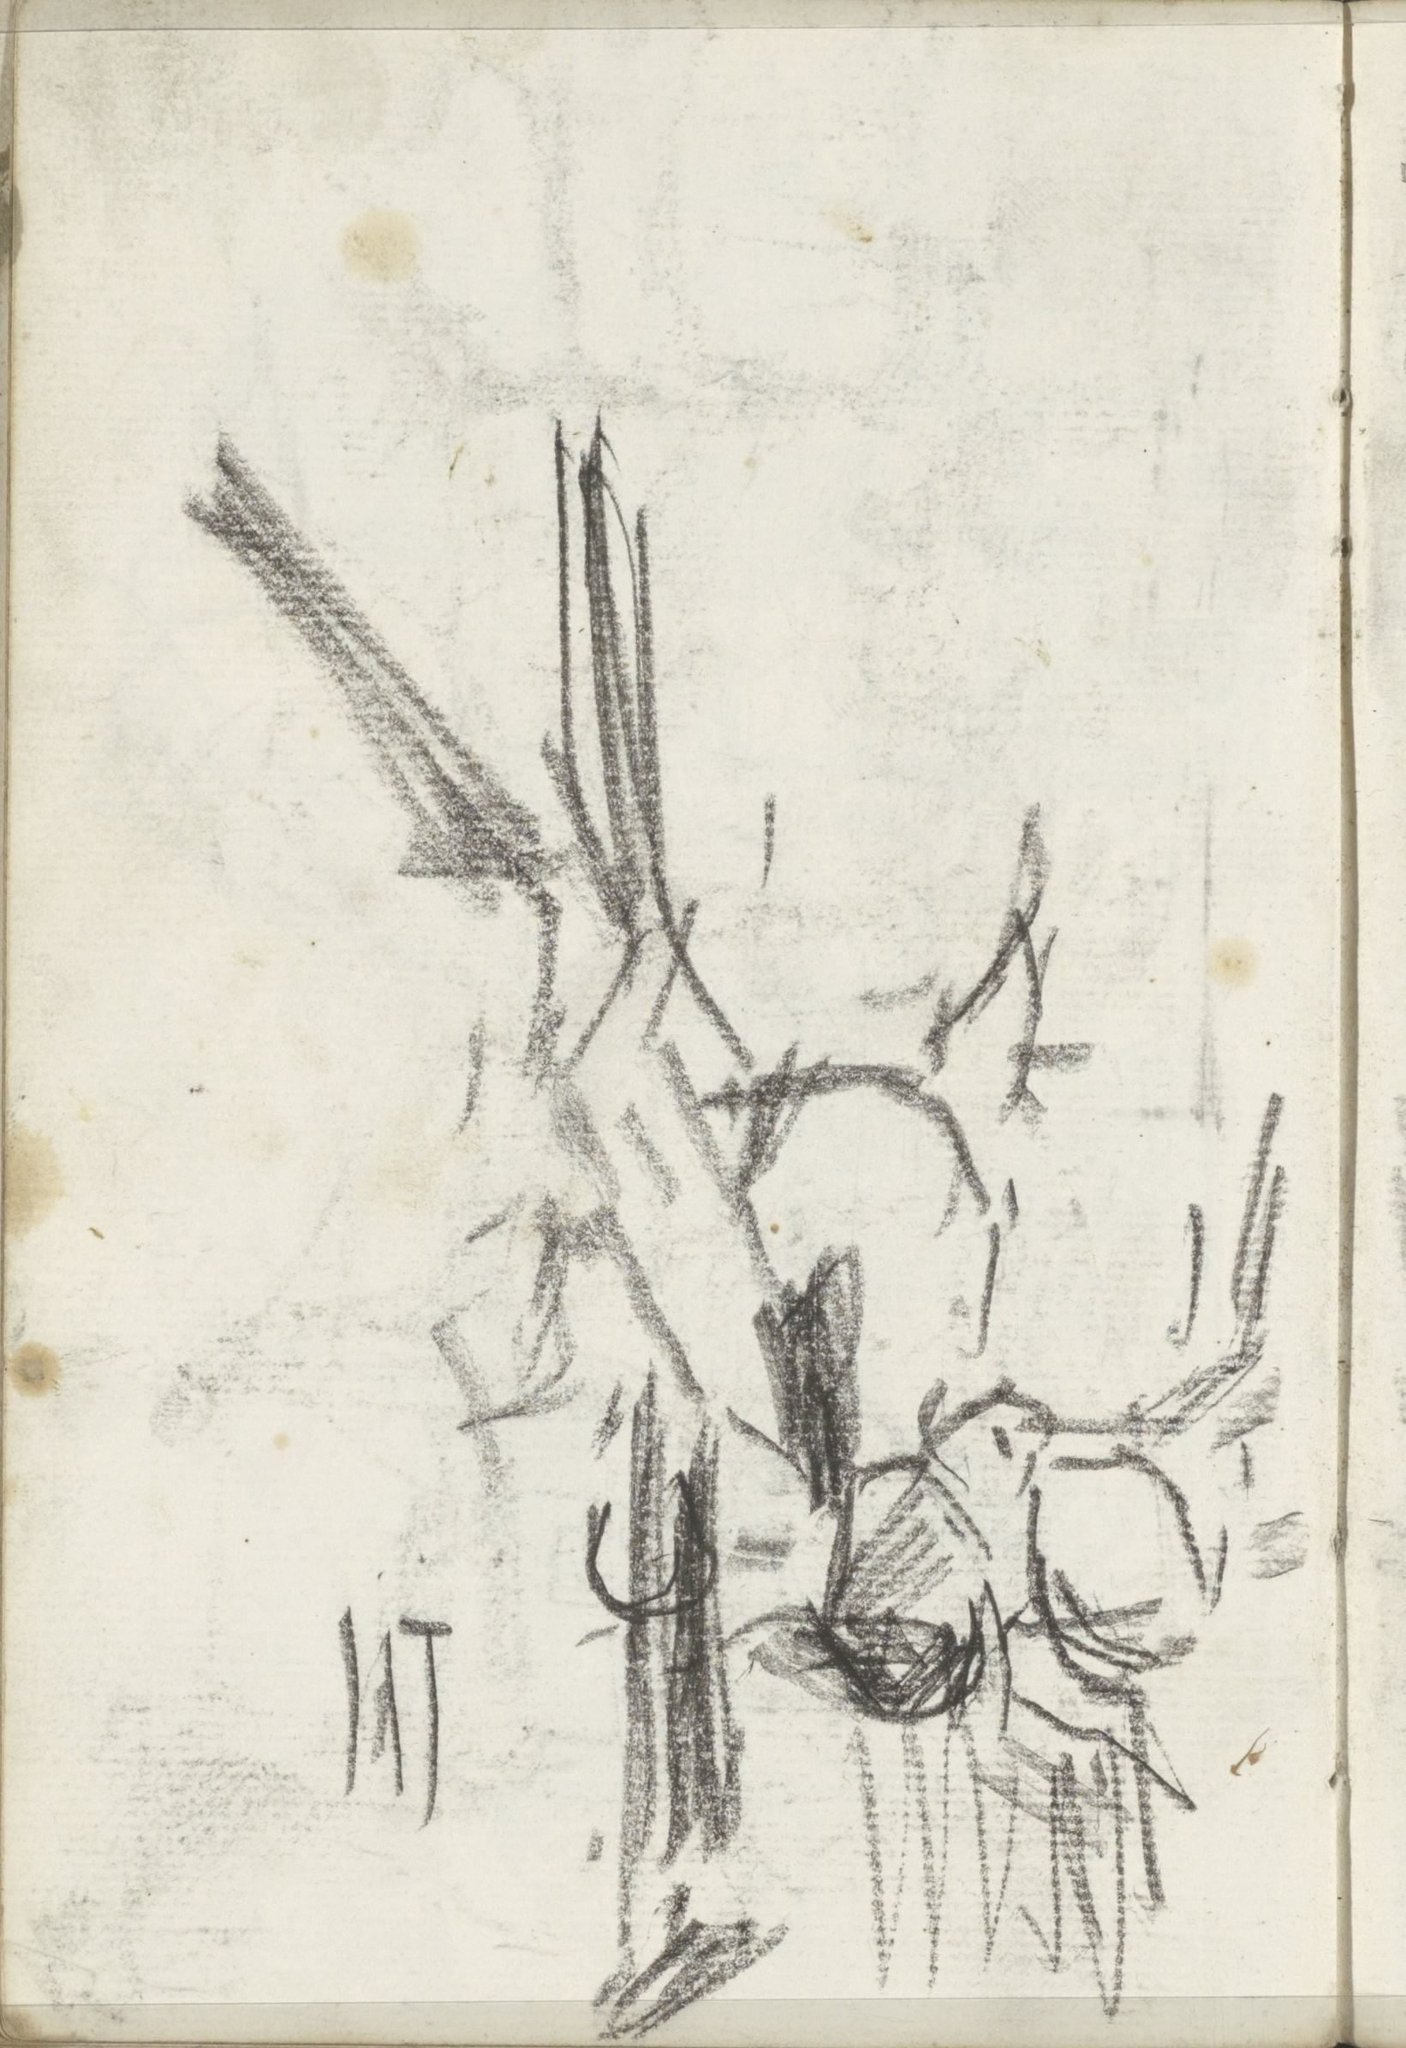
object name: sketchbook leaf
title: Vrouwen op straat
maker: george hendrik breitner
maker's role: draughtsman, painter, print maker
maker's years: 1857-1923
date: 1886-1898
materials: chalk, paper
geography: amsterdam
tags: adult woman, street (+ city(-scape) with figures, staffage), amsterdam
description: Pagina 37 uit een schetsboek met 21 bladen.